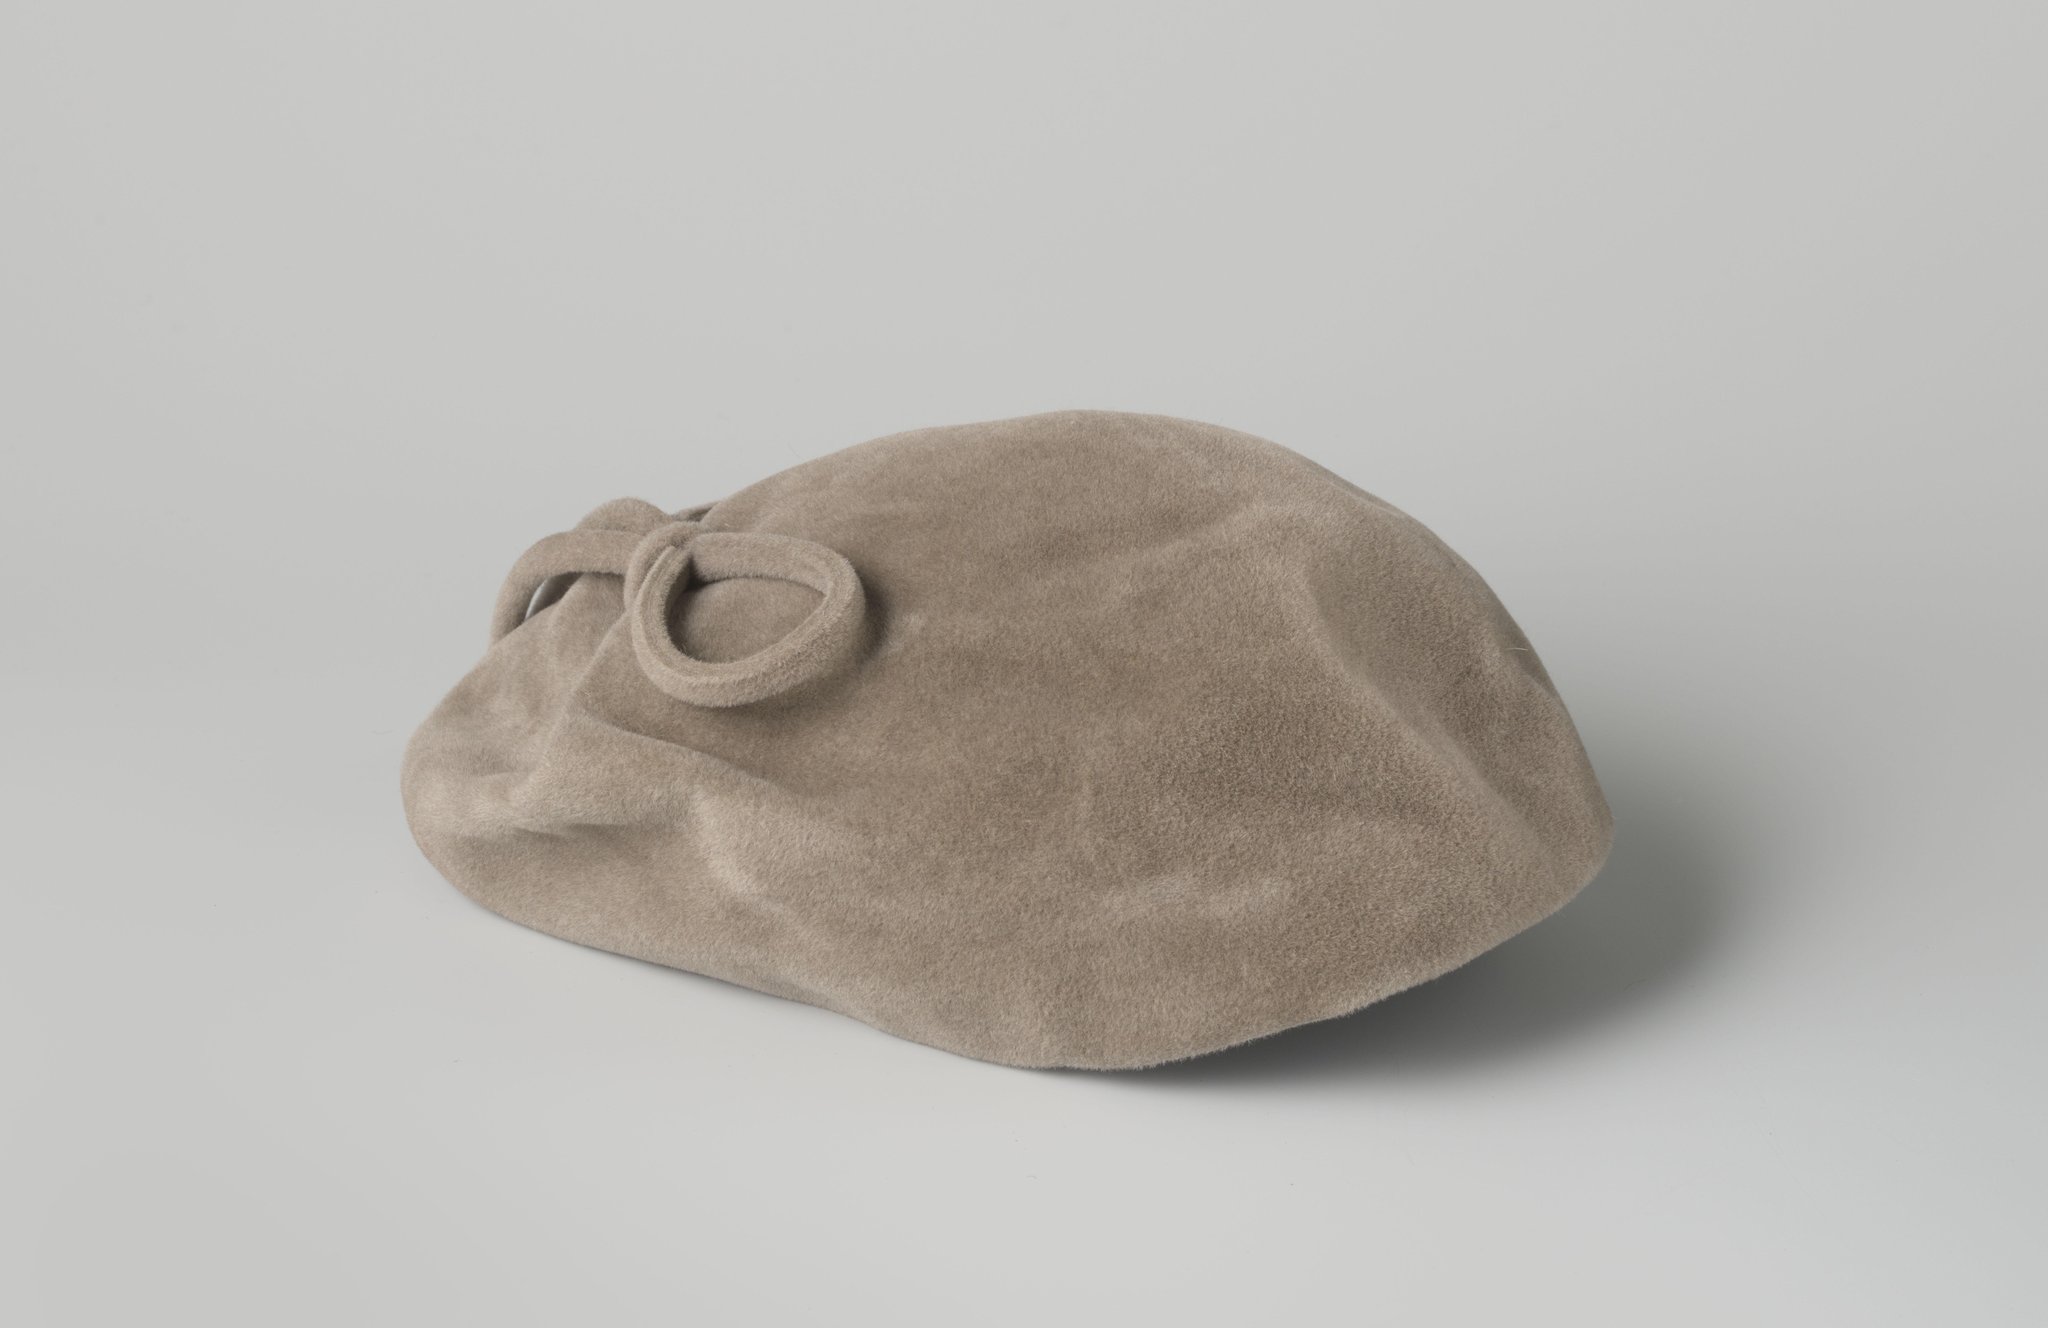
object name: beret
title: Baret van zilvergrijs fluweelvilt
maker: Anonymous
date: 1935-1940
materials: felt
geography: france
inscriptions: label: ‘NÉODAIM // VELOURS // MADE IN FRANCE’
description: Hoed van zilvergrijs fluweelvilt. Baret, schuin op rechter oor gedragen, van slap ongevoerde capeline, met een ingenaaide vouw. Dubbelgestikte reep vilt is rechts opzij viermaal door de hoed heen gestoken en vormt bovenop een lus met twee uiteinden.